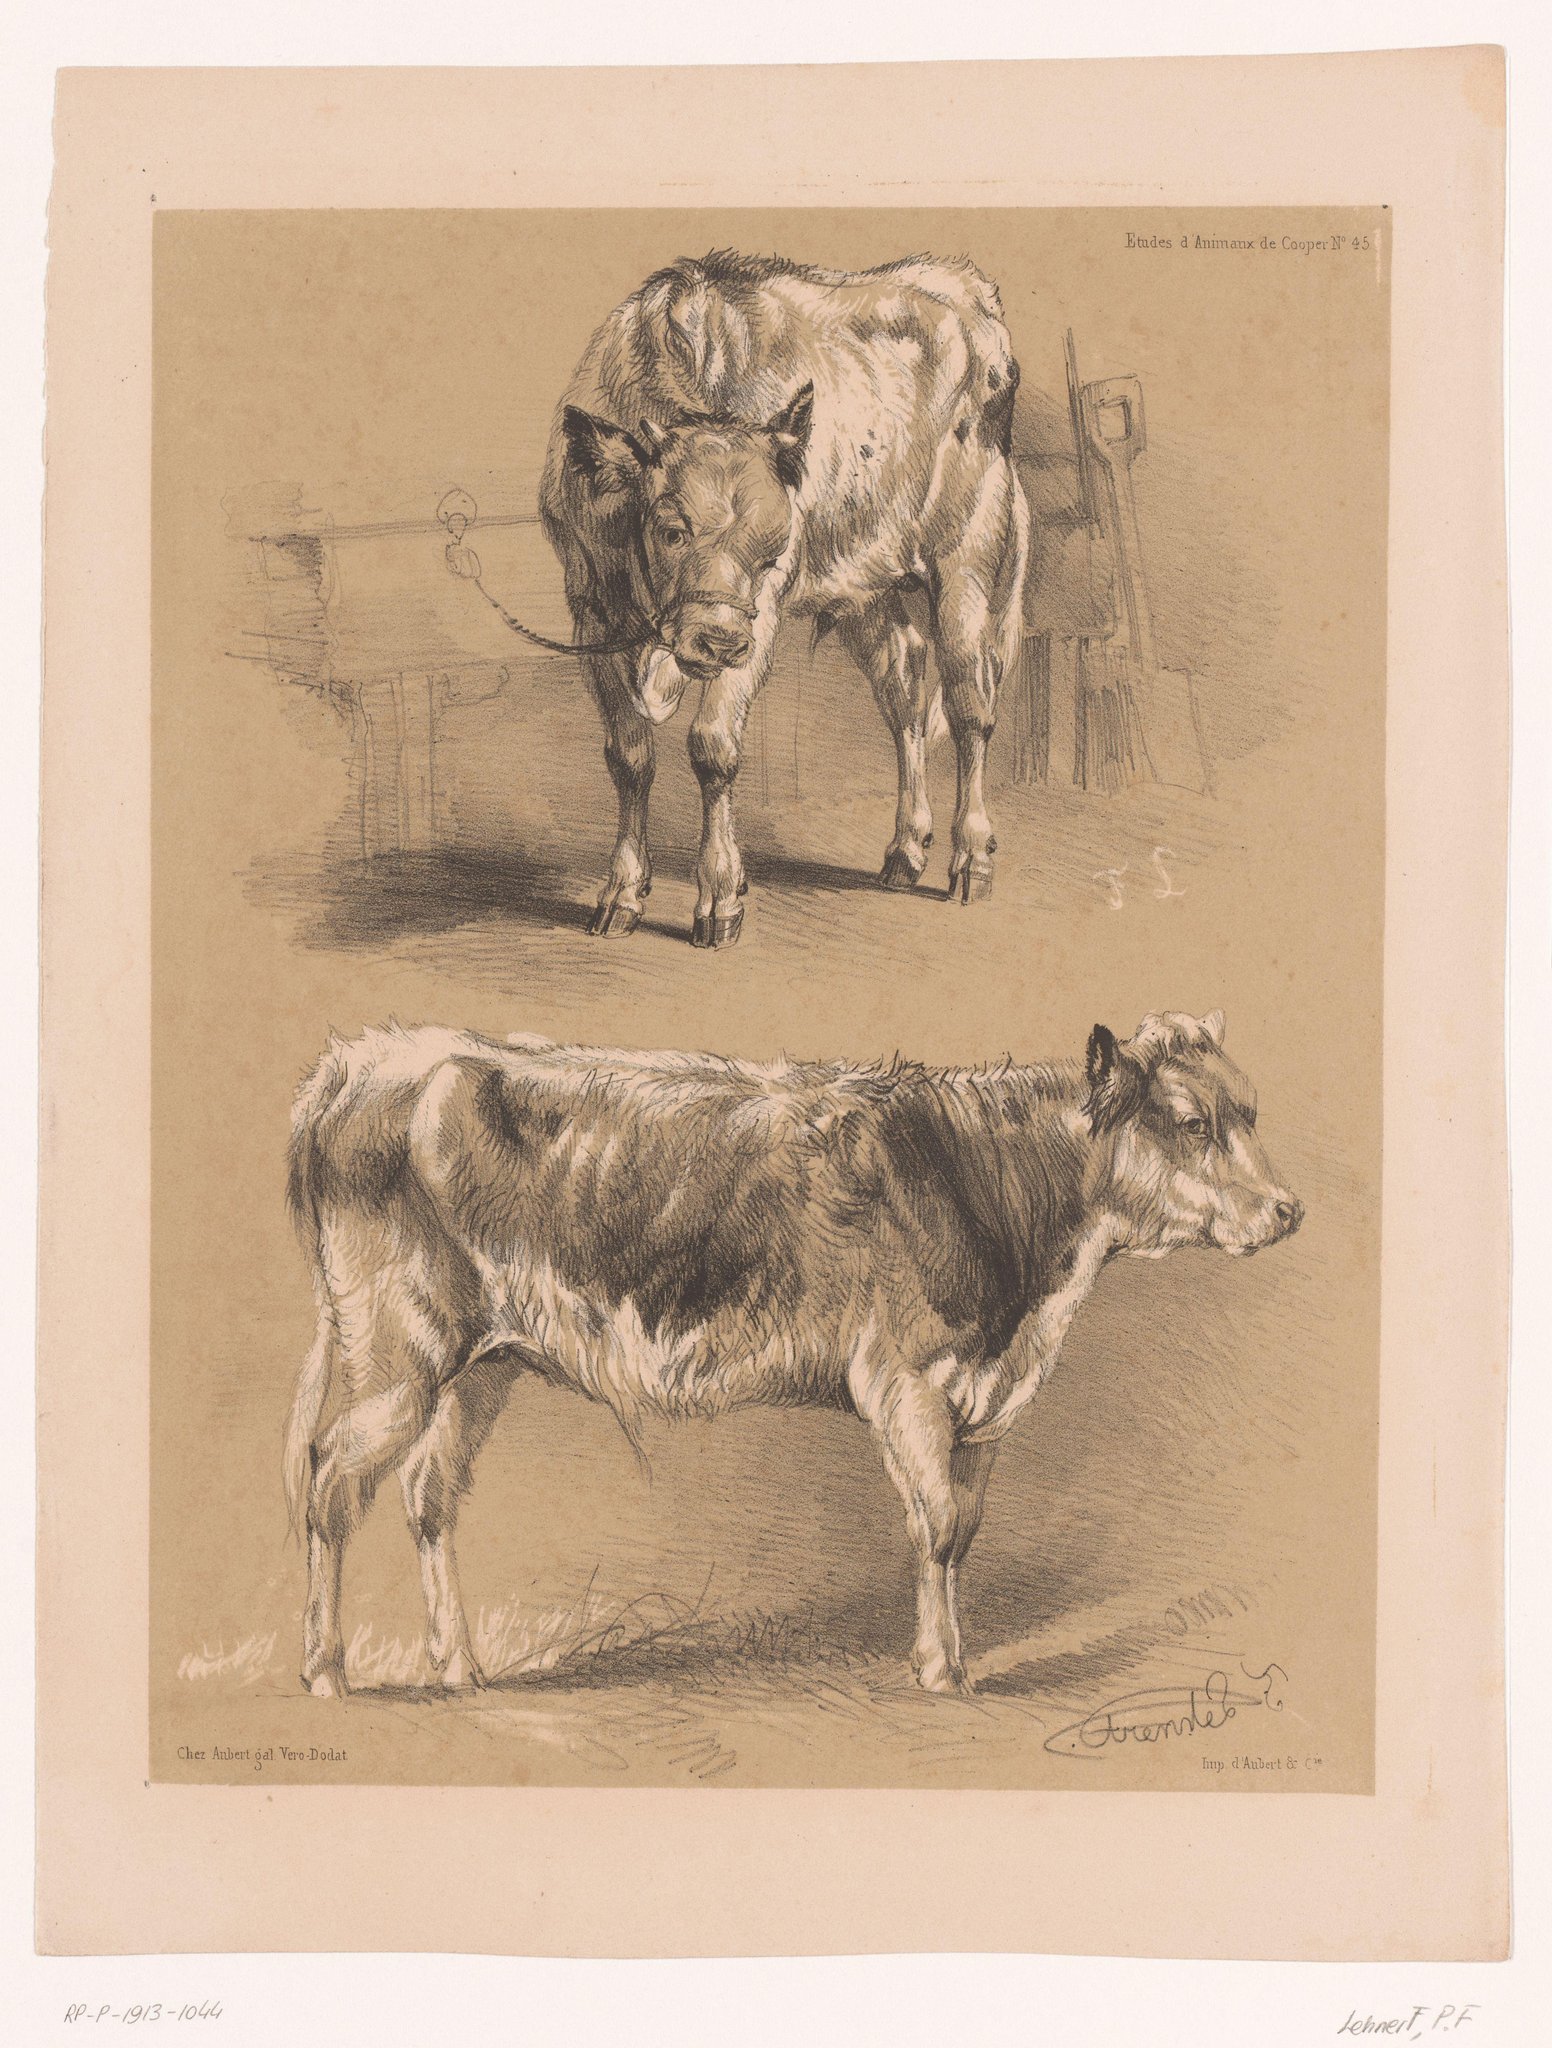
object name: print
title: Études d'Animaux de Cooper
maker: pierre frédéric lehnert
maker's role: print maker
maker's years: 1811-1880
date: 1838-1840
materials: paper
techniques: tone lithography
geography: paris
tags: bull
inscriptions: collector's mark: Lugt 2228a